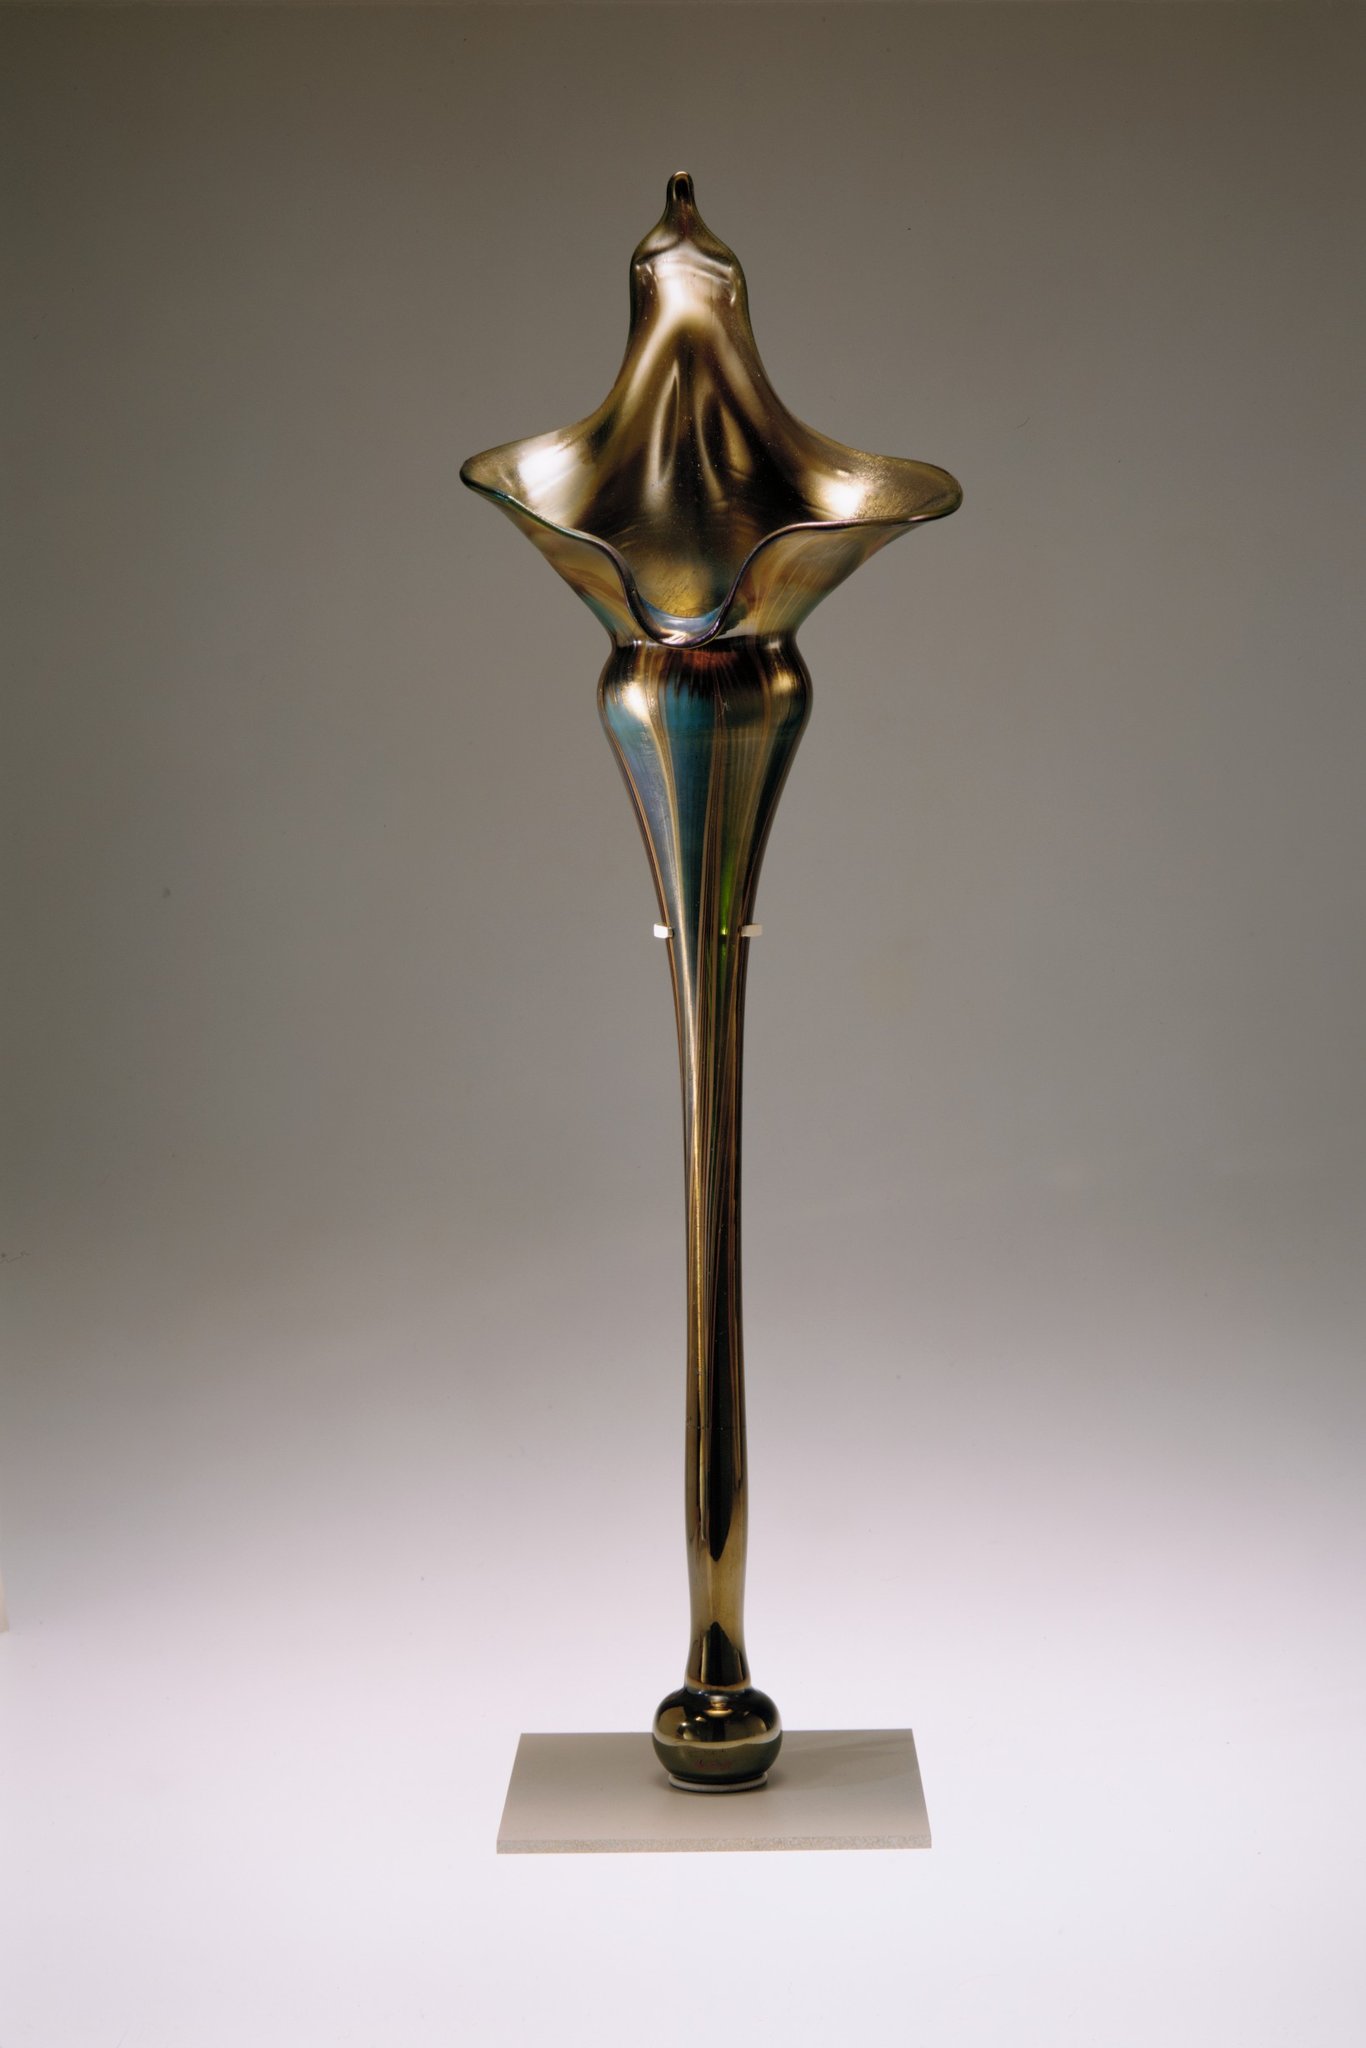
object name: hanging vase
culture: american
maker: louis c. tiffany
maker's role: designer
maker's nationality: american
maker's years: 1848-1933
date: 1893-1896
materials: glass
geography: united states